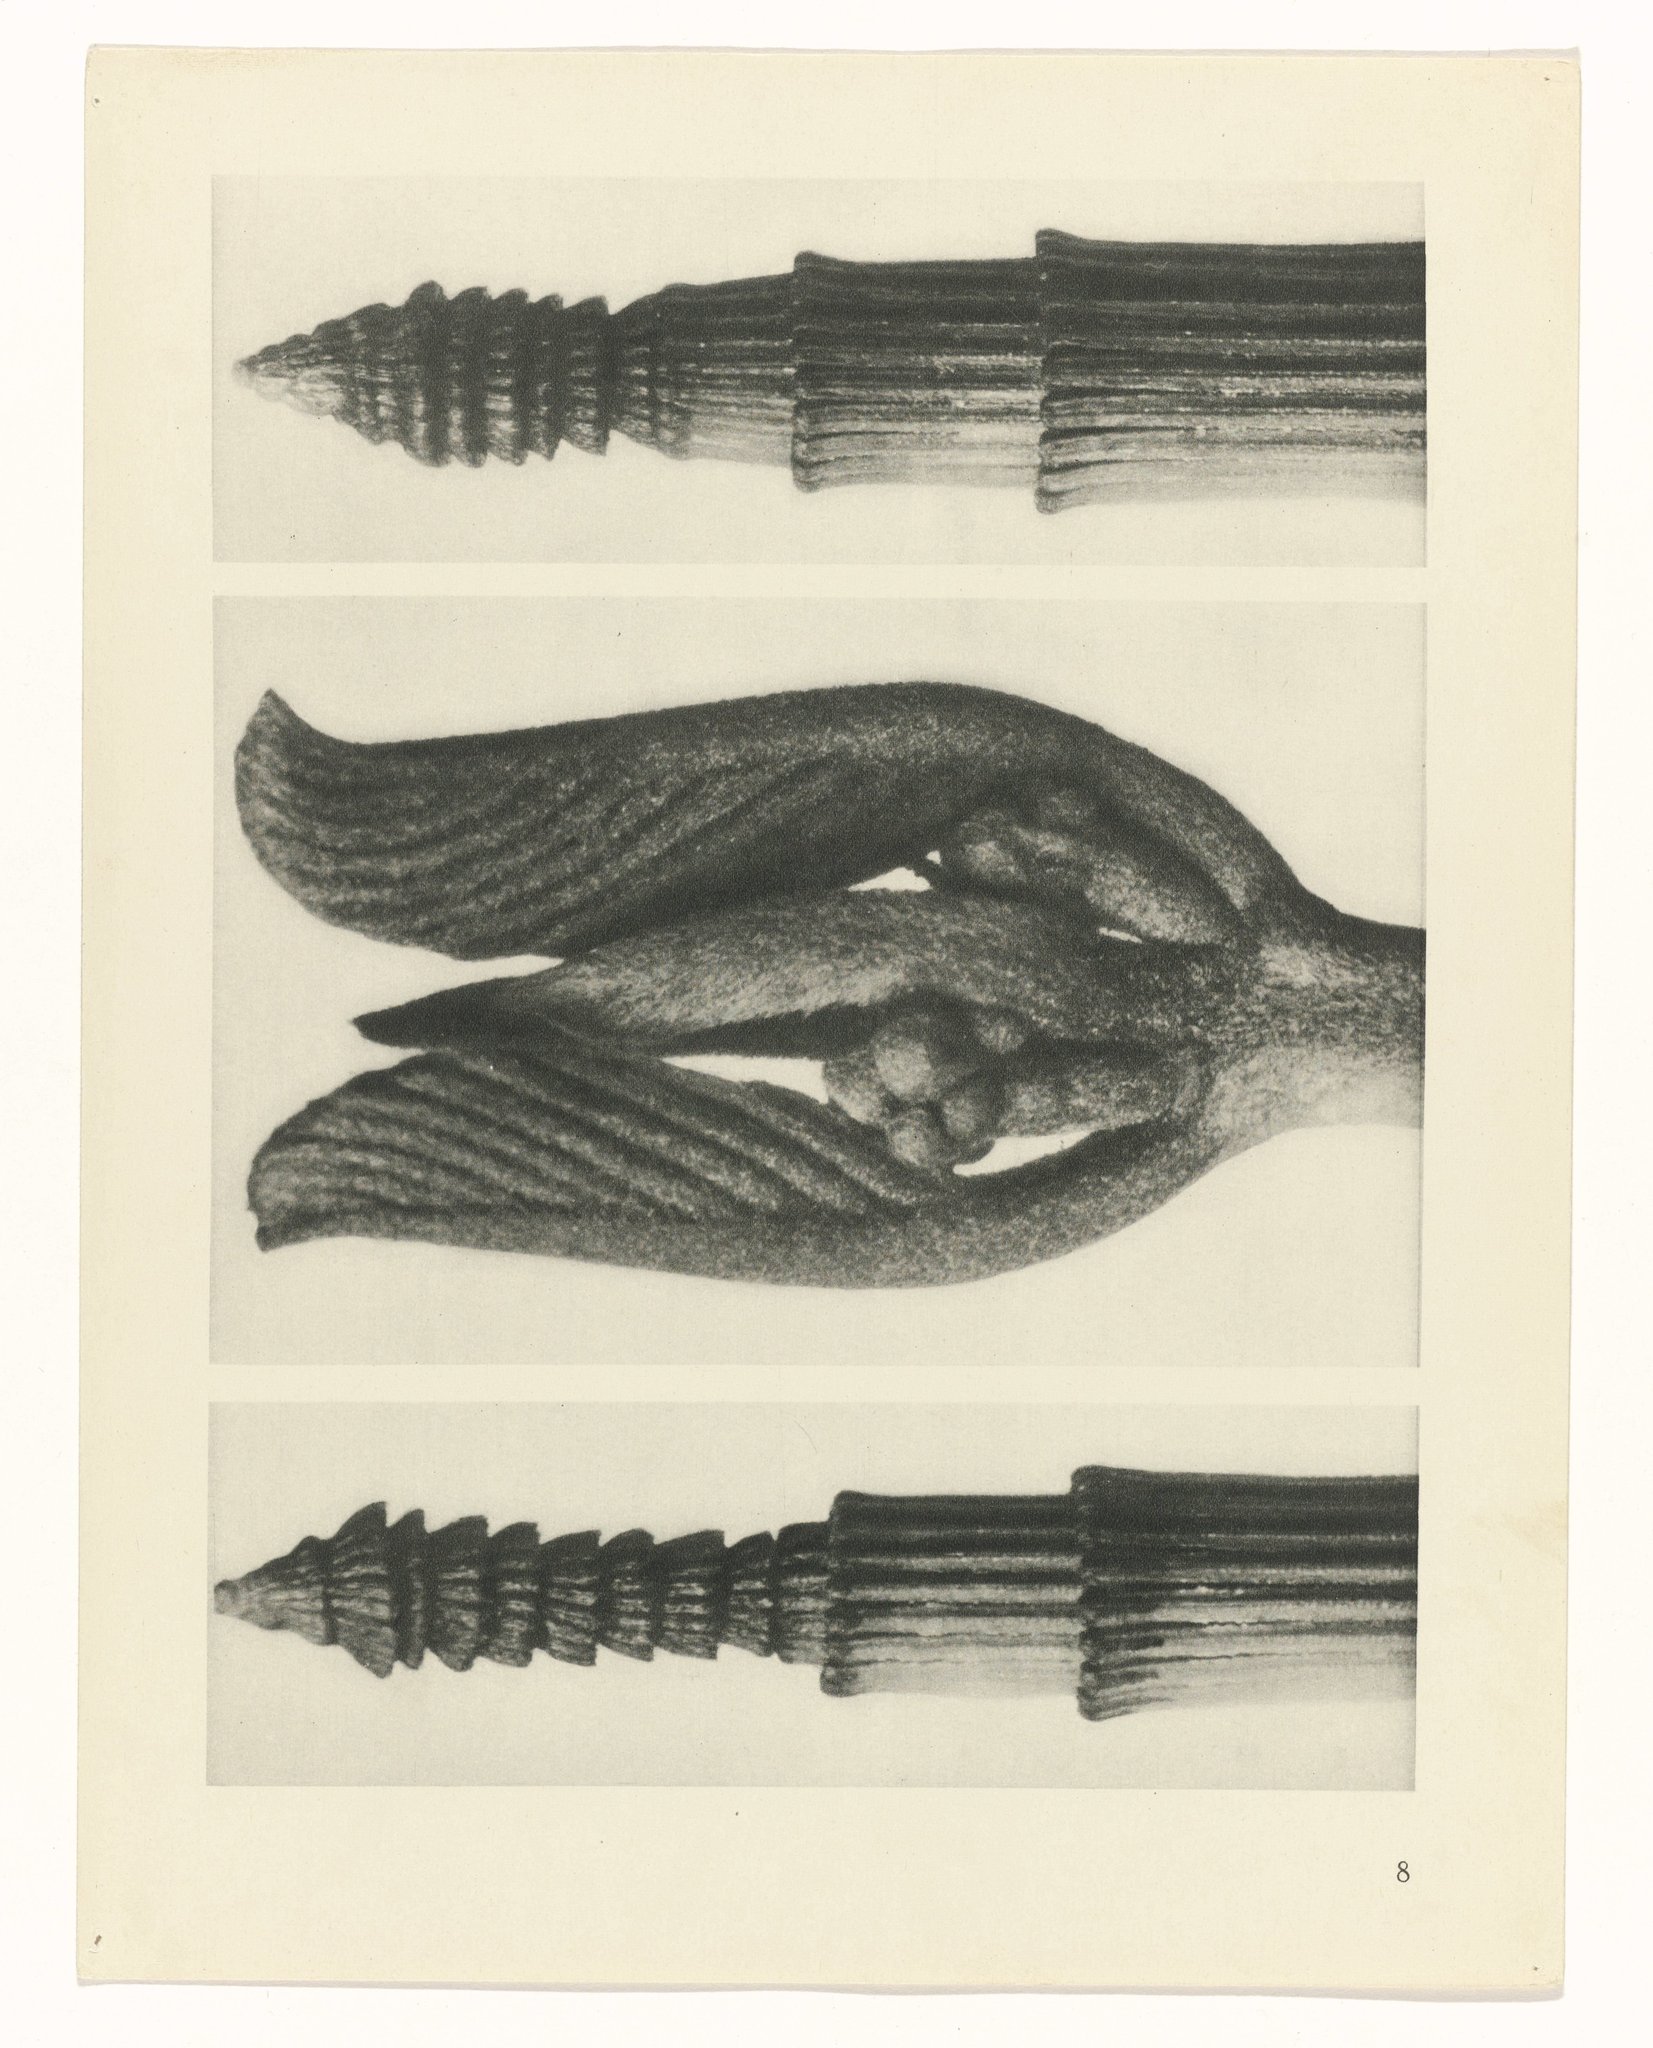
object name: photograph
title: Urformen der Kunst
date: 1928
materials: ink, paper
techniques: rotogravure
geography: berlin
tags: plants (in general)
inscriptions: number: ‘8’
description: facher Vergrößerung. Afkomstig uit losbladige uitgave.